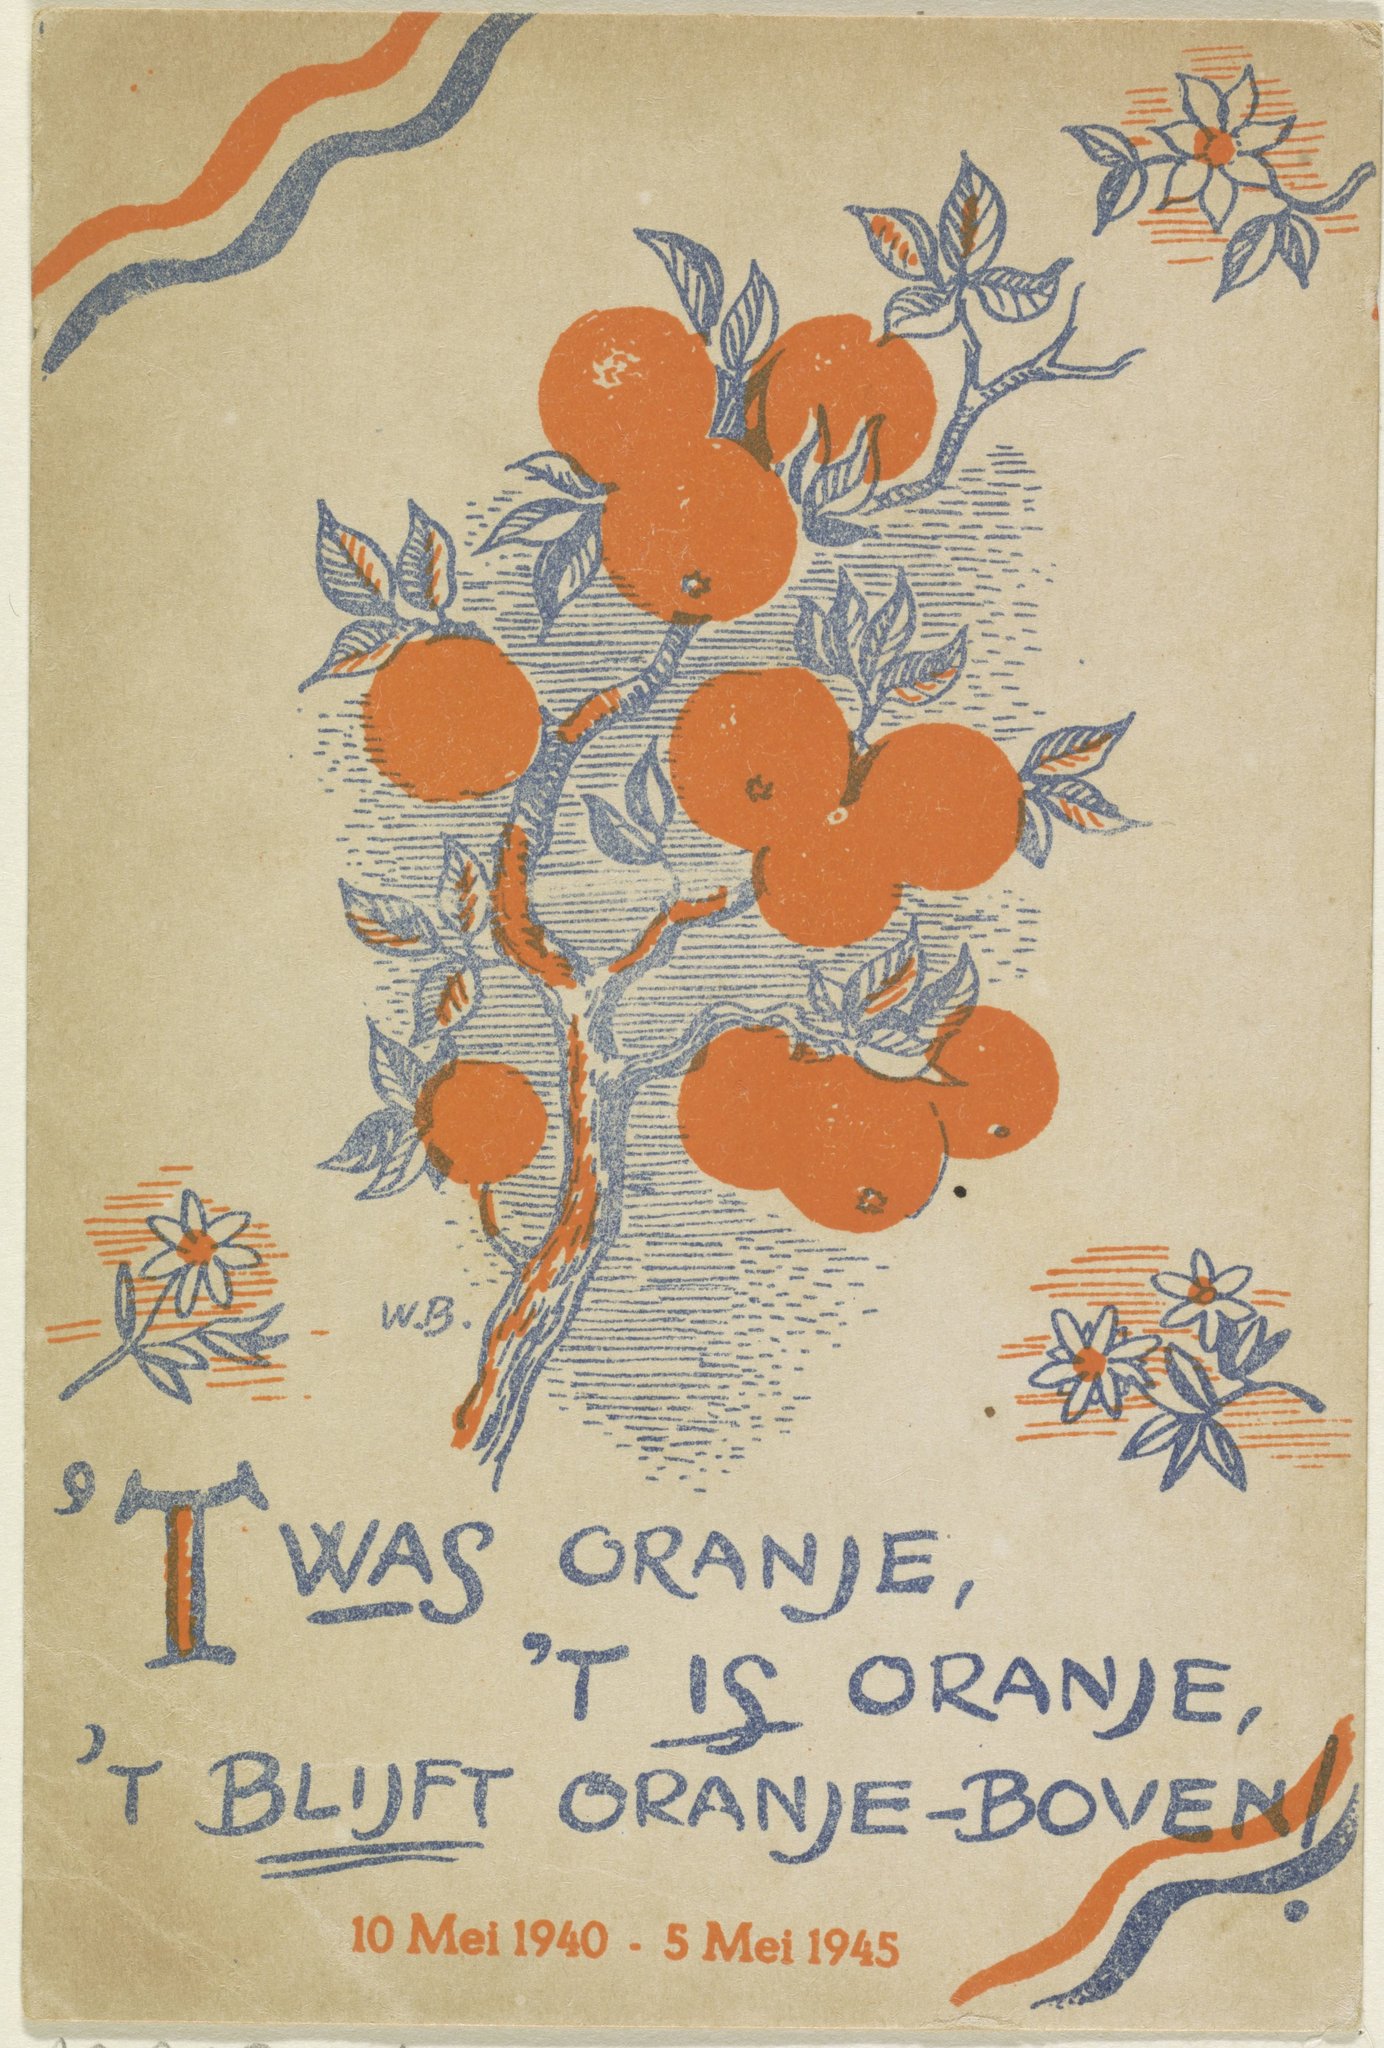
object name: print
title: Feestplaat ter ere van de bevrijding van Nederland op 5 mei 1945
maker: monogrammist wb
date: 1945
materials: paper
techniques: lithograph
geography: netherlands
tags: bevrijding van nederland (1945)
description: Feestplaat ter ere van de bevrijding van Nederland op 5 mei 1945. In het midden een oranjetak met bladeren en vruchten. Daar omheen bloesem van een oranjeboom en linten met de Nederlandse vlag. Eronder drie regels Nederlandse tekst en de data '10 Mei 1940-5 Mei 1945'.